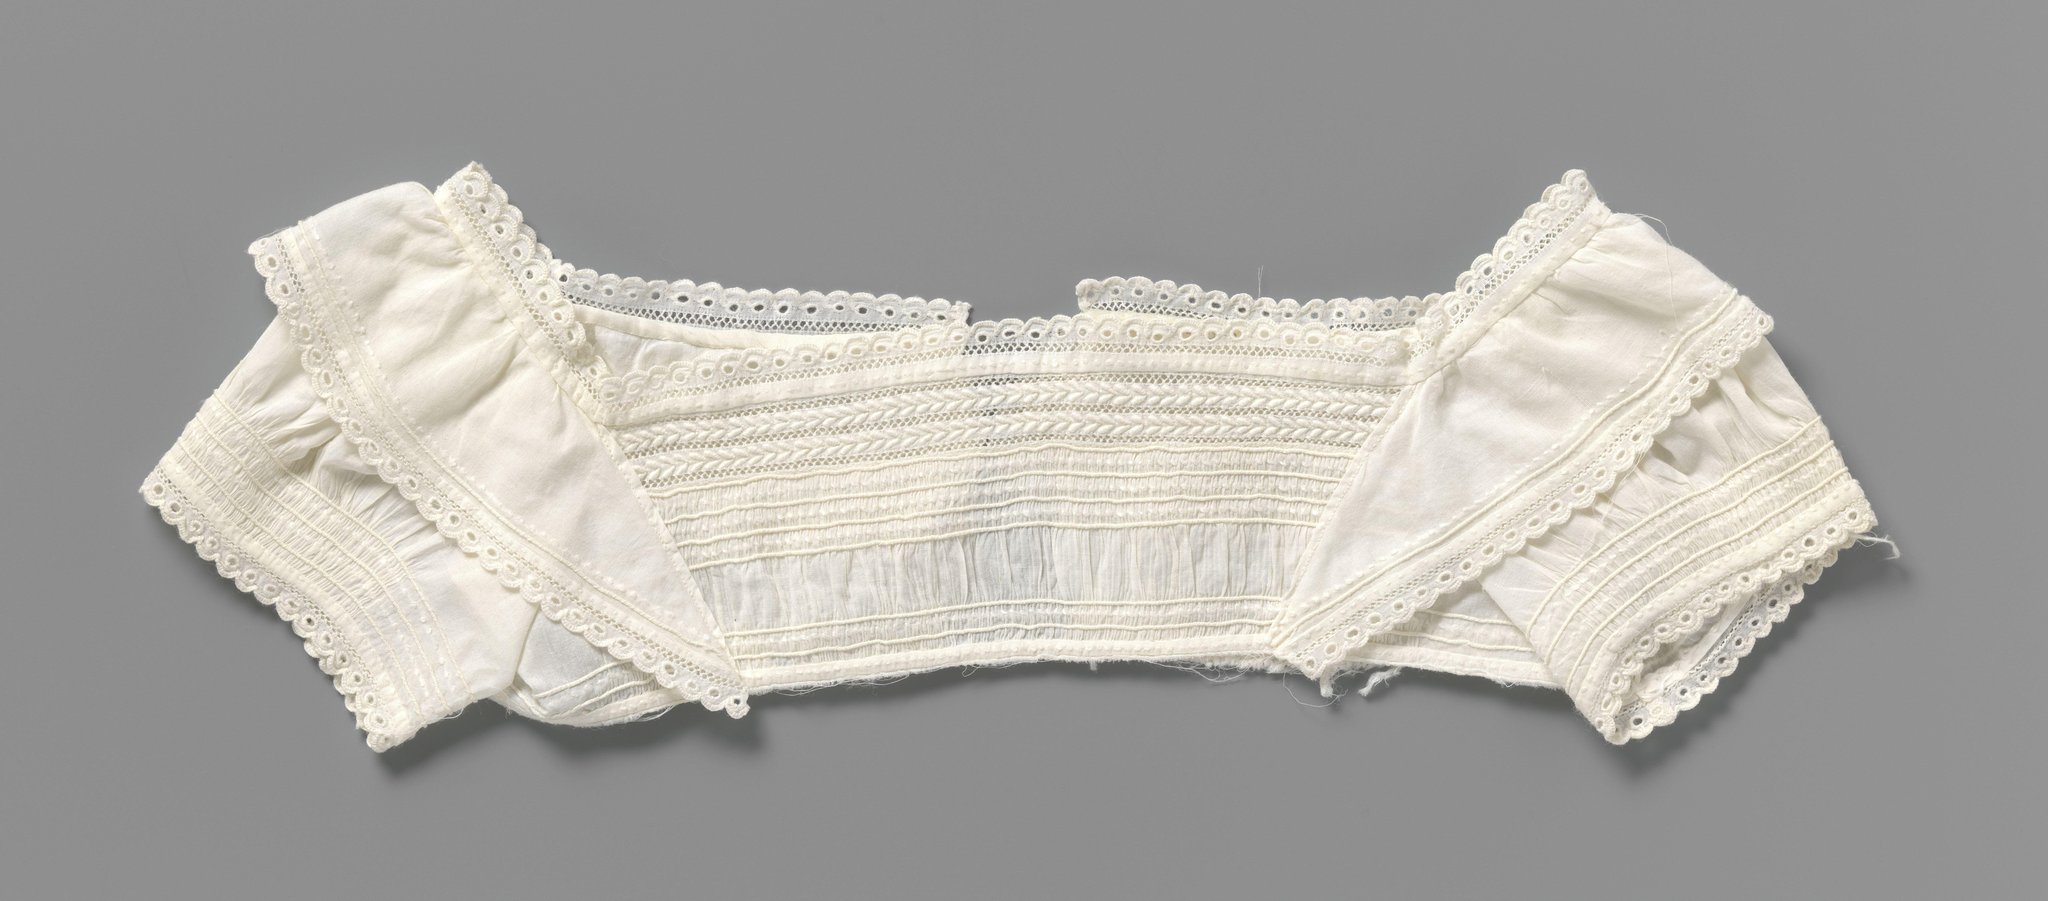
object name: childrenswear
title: Een lijf van een babyjurk, van fijn batist, met geborduurde, driehoekige voorpandversieringen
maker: Anonymous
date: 1830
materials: textile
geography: netherlands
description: Een lijf van een babyjurk, van fijn batist, met geborduurde, driehoekige voorpandversieringen. Biedermeier.